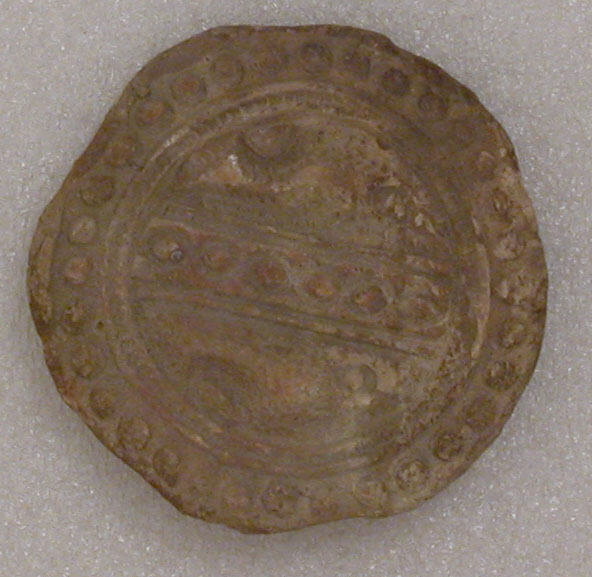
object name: seal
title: Bread Seal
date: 901-1000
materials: earthenware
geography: egypt